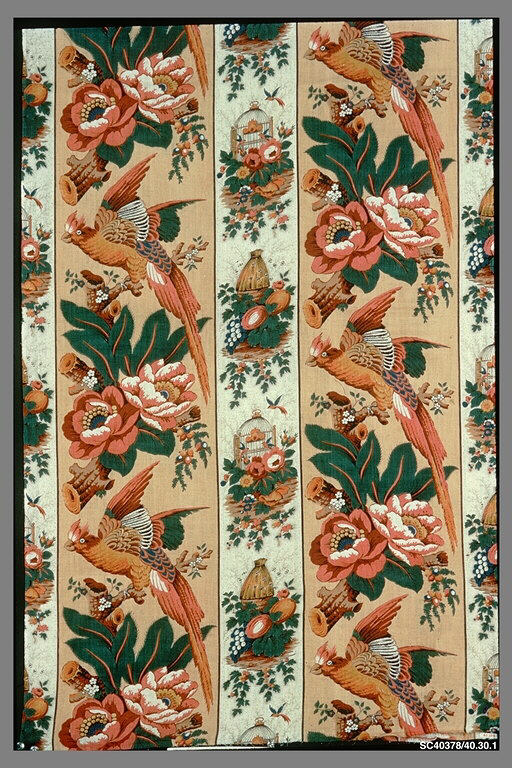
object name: curtain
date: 1801-1900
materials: cotton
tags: birds,flowers